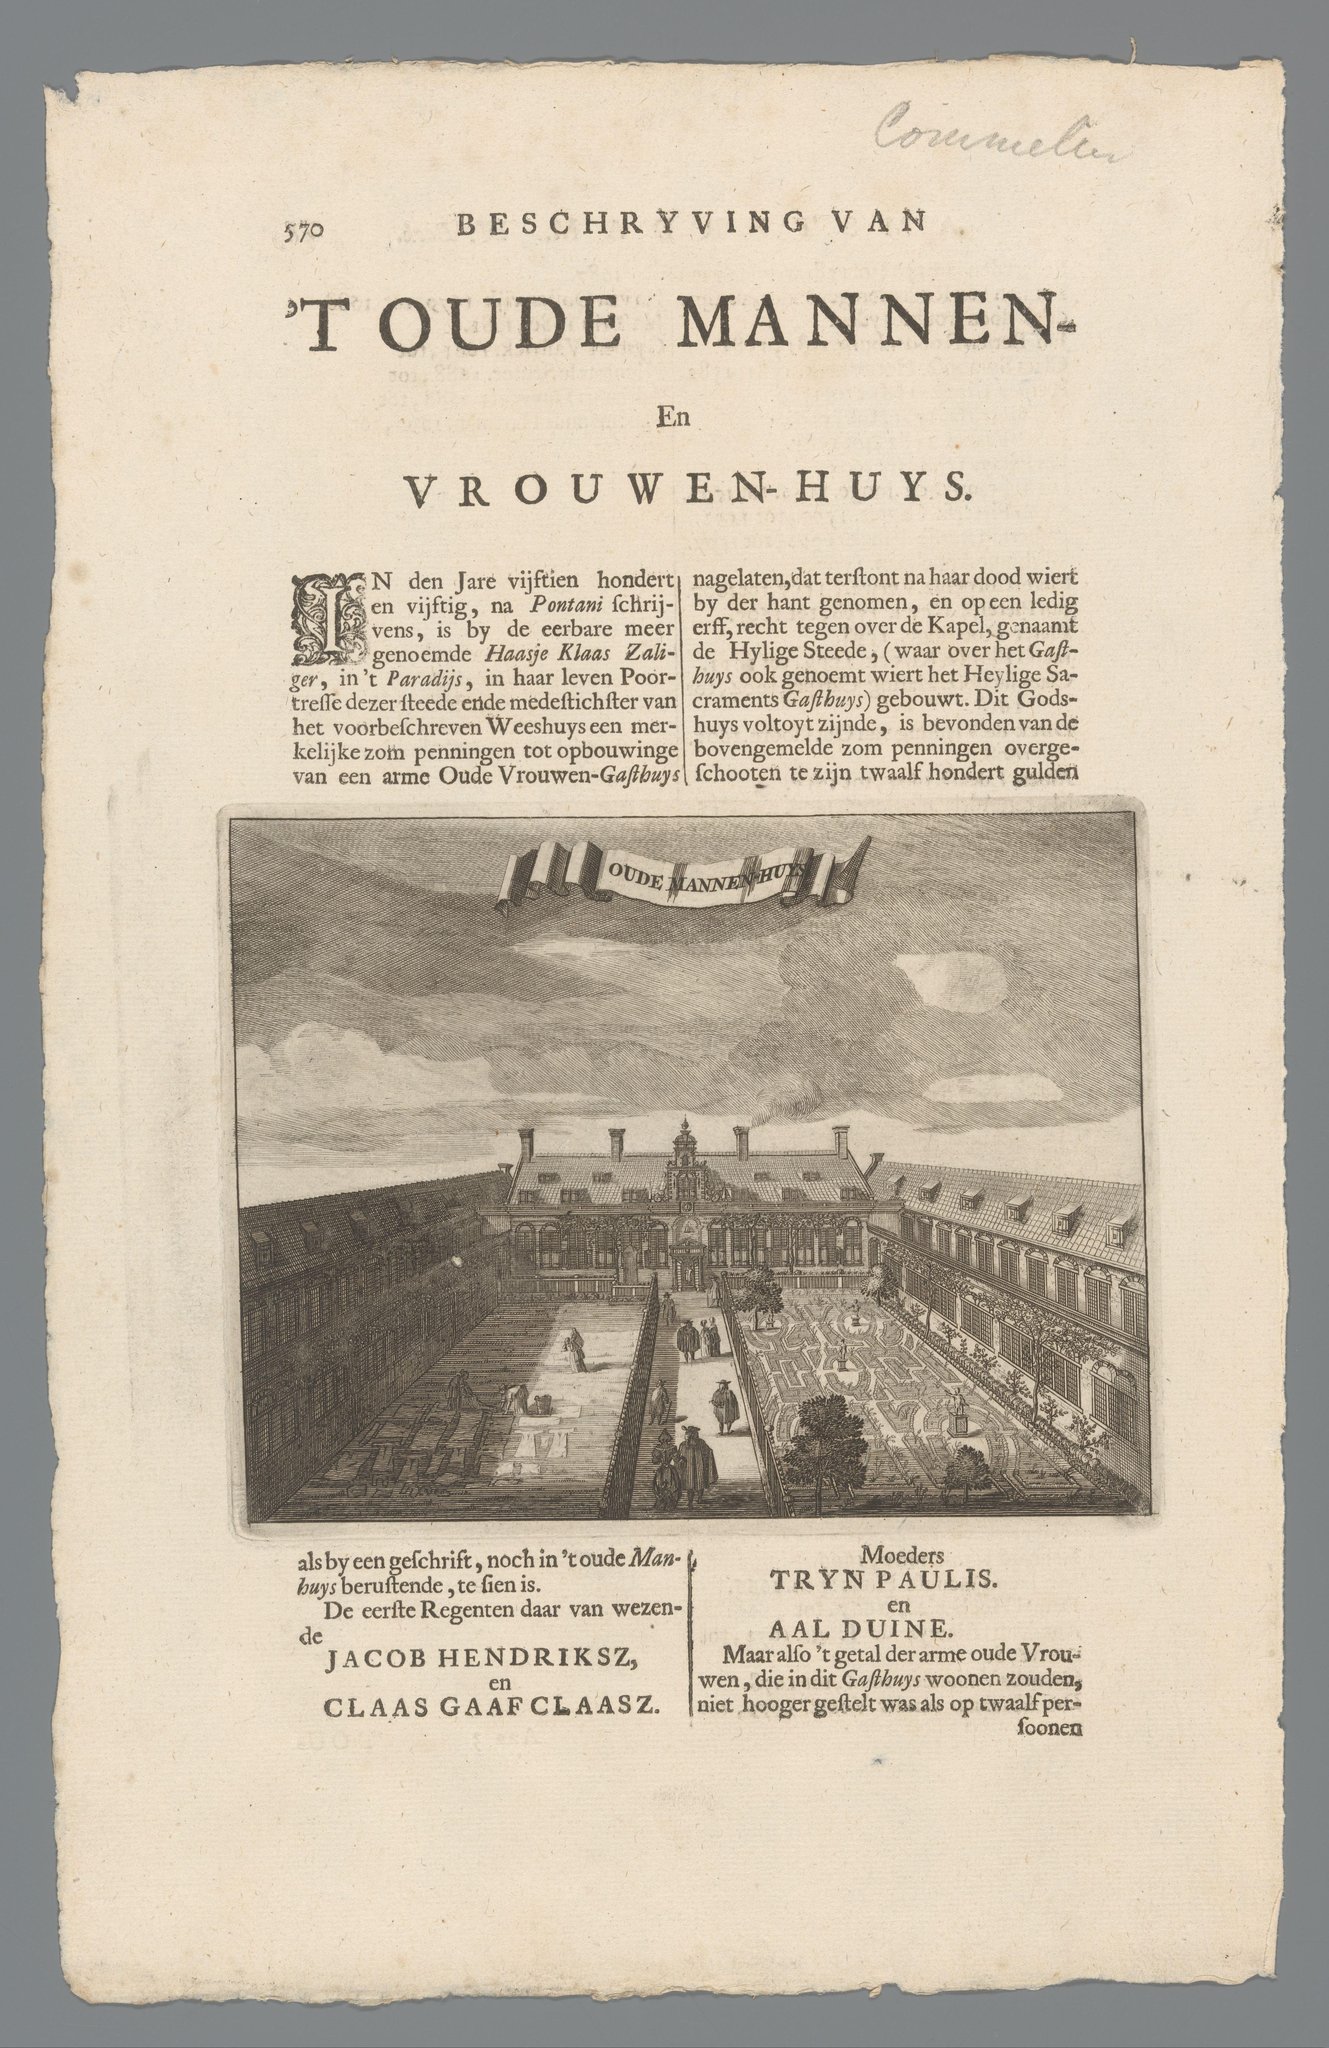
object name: print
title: Oude Mannen-huys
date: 1726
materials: paper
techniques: etching, letterpress printing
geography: amsterdam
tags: public welfare, courtyard, old-people's home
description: Prent uit: Commelin, Caspar. Beschryvinge van Amsterdam, zynde een naukeruige verhandelinge van desselfs eerste oorspronk uyt den Huyse (…). Amsterdam: Andries van Damme et al., 1726, p. 570.